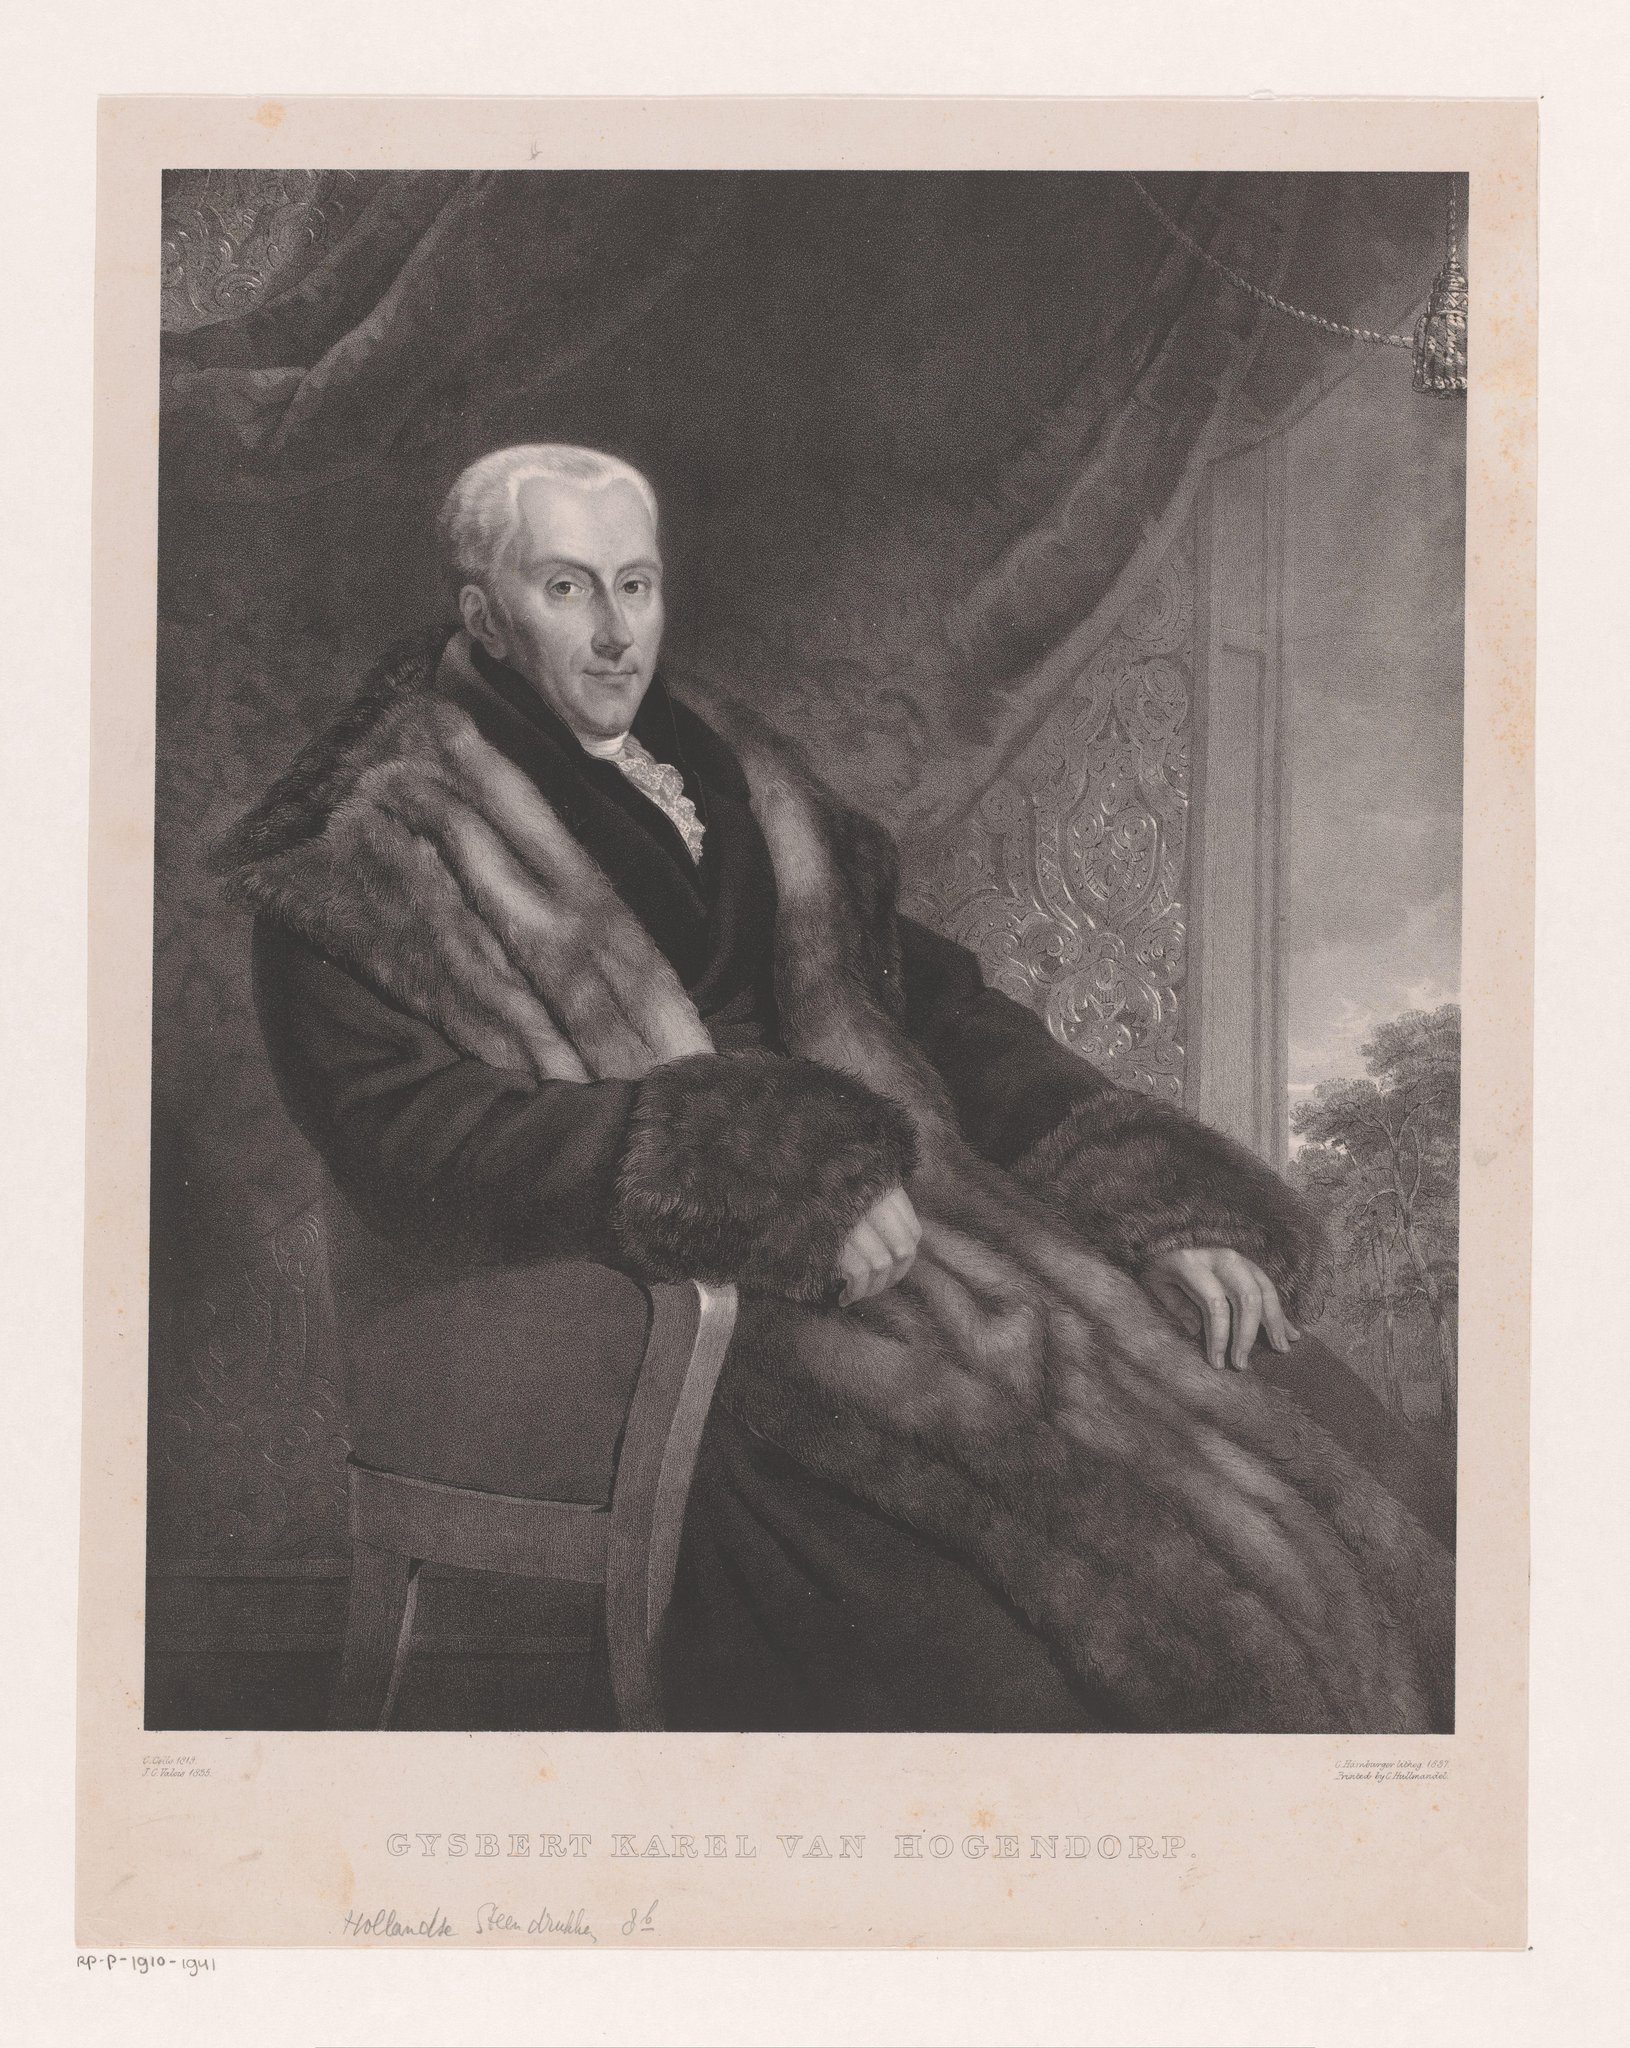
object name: print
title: Portret van Gijsbert Karel van Hogendorp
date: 1837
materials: paper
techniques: lithograph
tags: window-seat, historical persons (+ three-quarter length portrait)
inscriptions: collector's mark: Lugt 2228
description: De geportretteerde zit bij een raam en draagt een lange jas afgezet met bont. Onder het portret zijn familiewapen en de voor- en achterkant van een gedenkpenning.